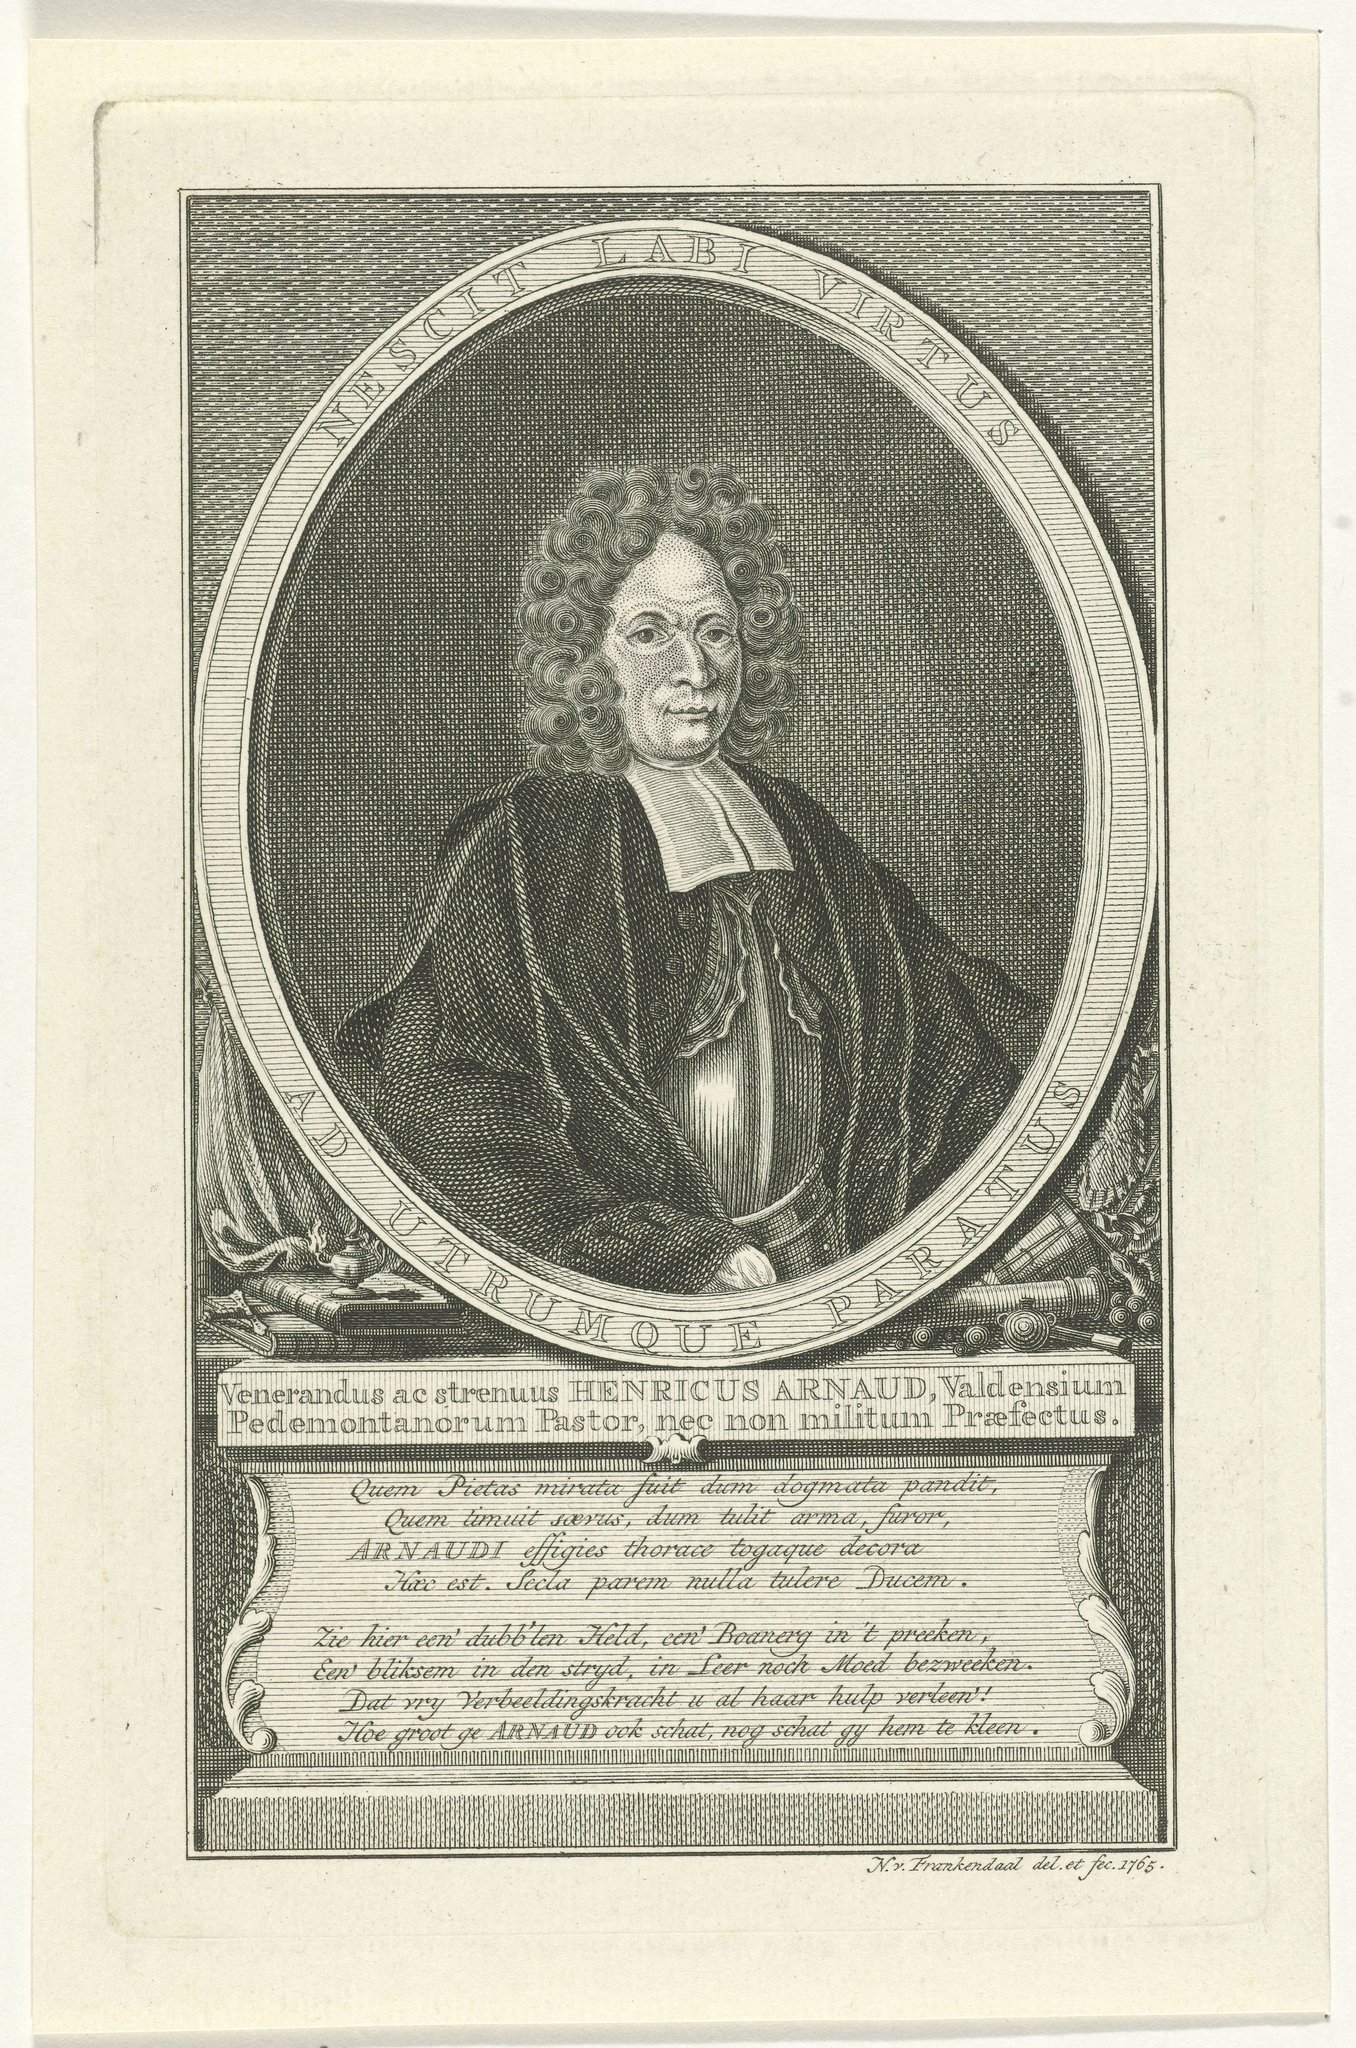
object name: print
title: Portret van Hendrik Arnaud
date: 1765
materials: paper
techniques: engraving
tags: kapitein, hendrik arnaud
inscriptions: date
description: Portret in ovale omlijsting van leraar en veldheer der Waldenzen Hendrik Arnaud, ten halven lijve naar rechts. Arnaud is blootshoofds, draagt een bef en toga en is gehuld in een harnas. Het portret heeft een randschrift en staat op een sokkel waarop een vierregelige tekst in Latijn en Nederlands staat.